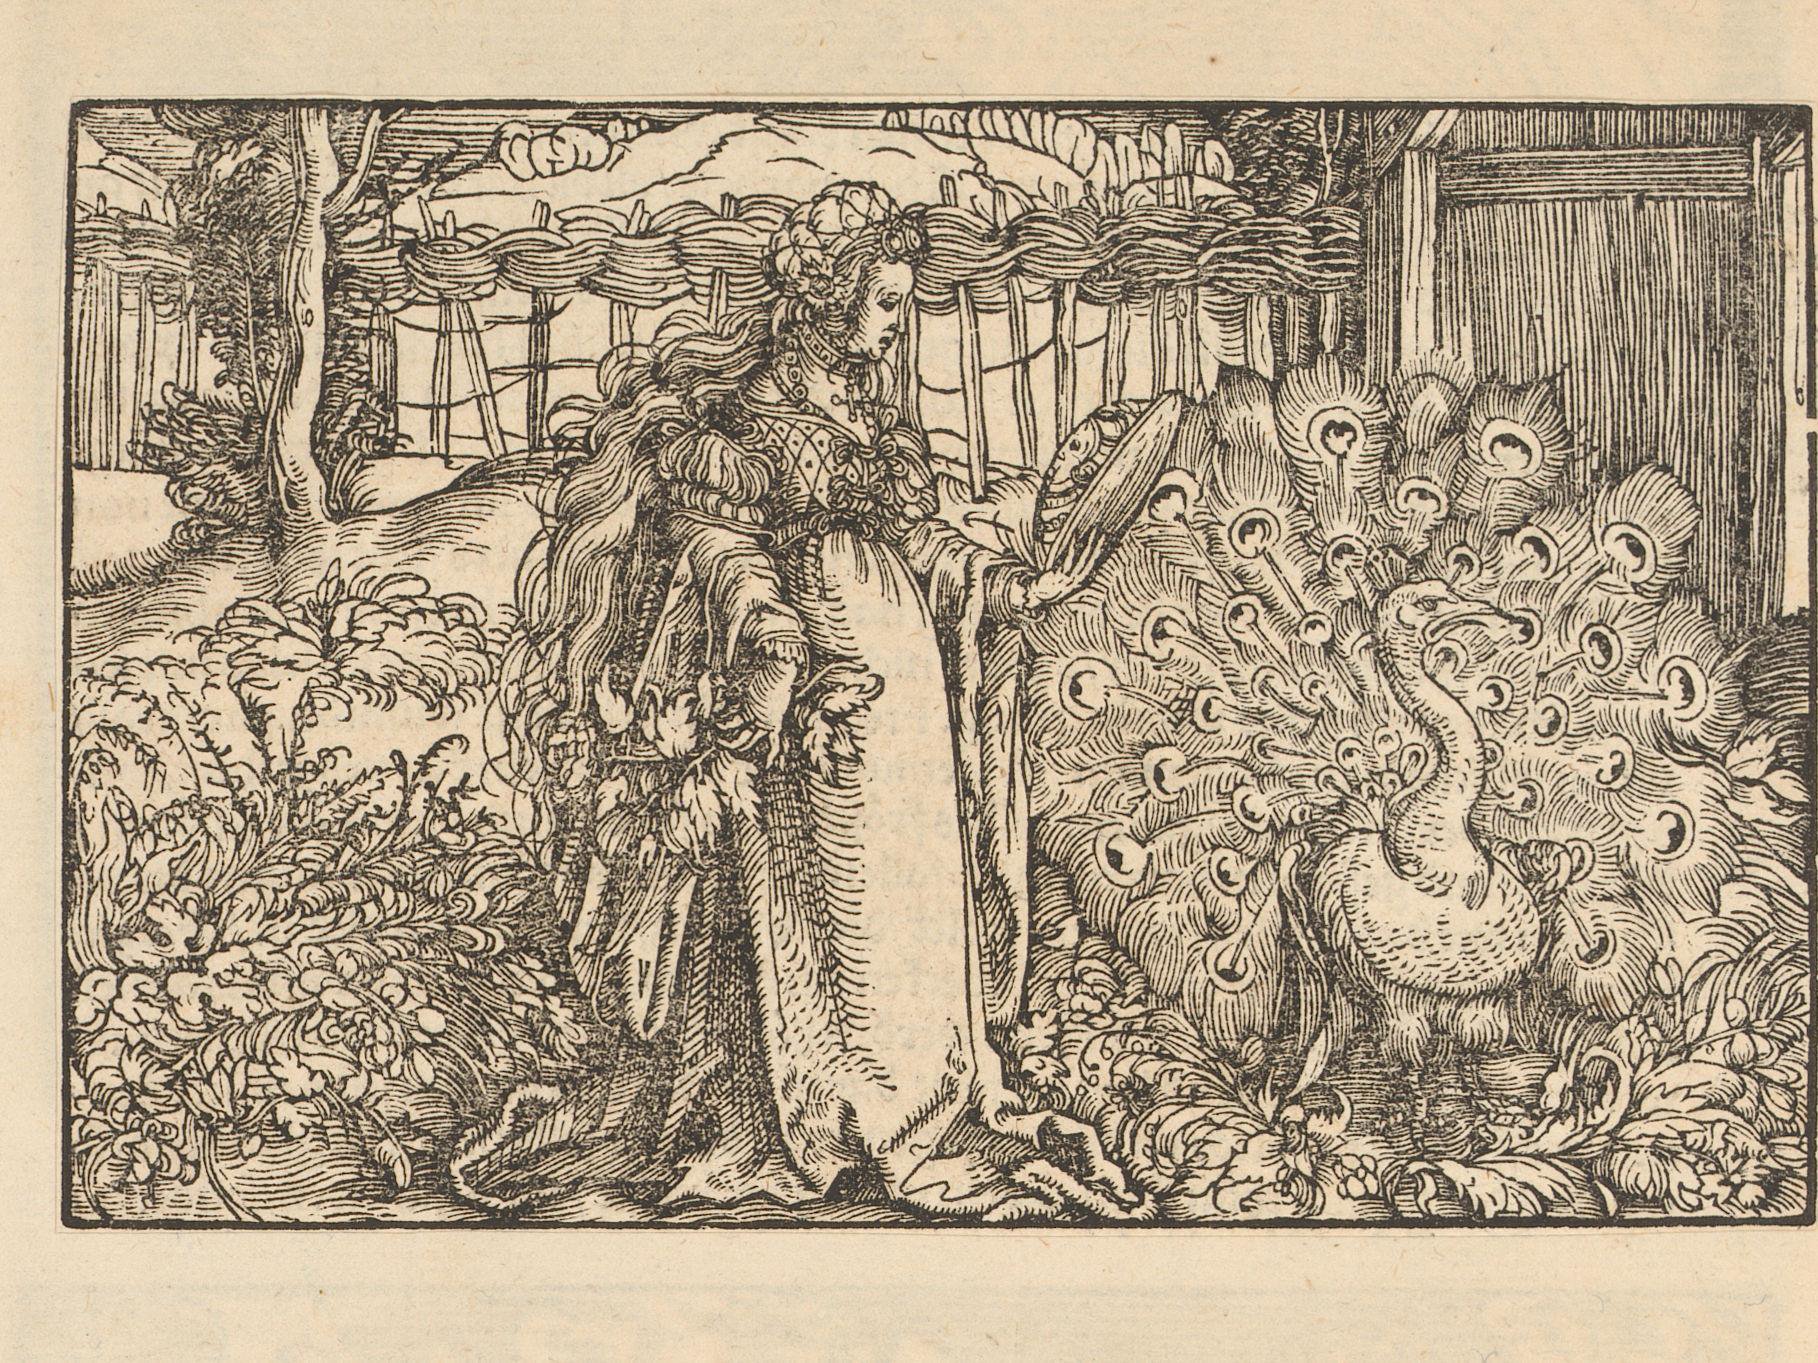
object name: book illustration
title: Vrouw met pauw bekijkt zichzelf in een handspiegel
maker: Anonymous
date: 1514-1532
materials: paper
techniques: letterpress printing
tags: looking in the mirror; (possibly: contemplation of own beauty - aa - (for) women), ornamental birds: peacock, (woman) looking in a mirror ~ scene symbolizing 'vanitas'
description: Deze prent is gebruikt in: Petrarca, Francesco. Von der Artzney bayder Glück, des guten und widerwertigen: unnd weß sich ain yeder inn Gelück und Unglück halten sol (...). Augsburg: Heinrich Steiner, 1532. Deze uitgave is ook bekend onder de titel 'Trostspiegel in Glück und Unglück'.